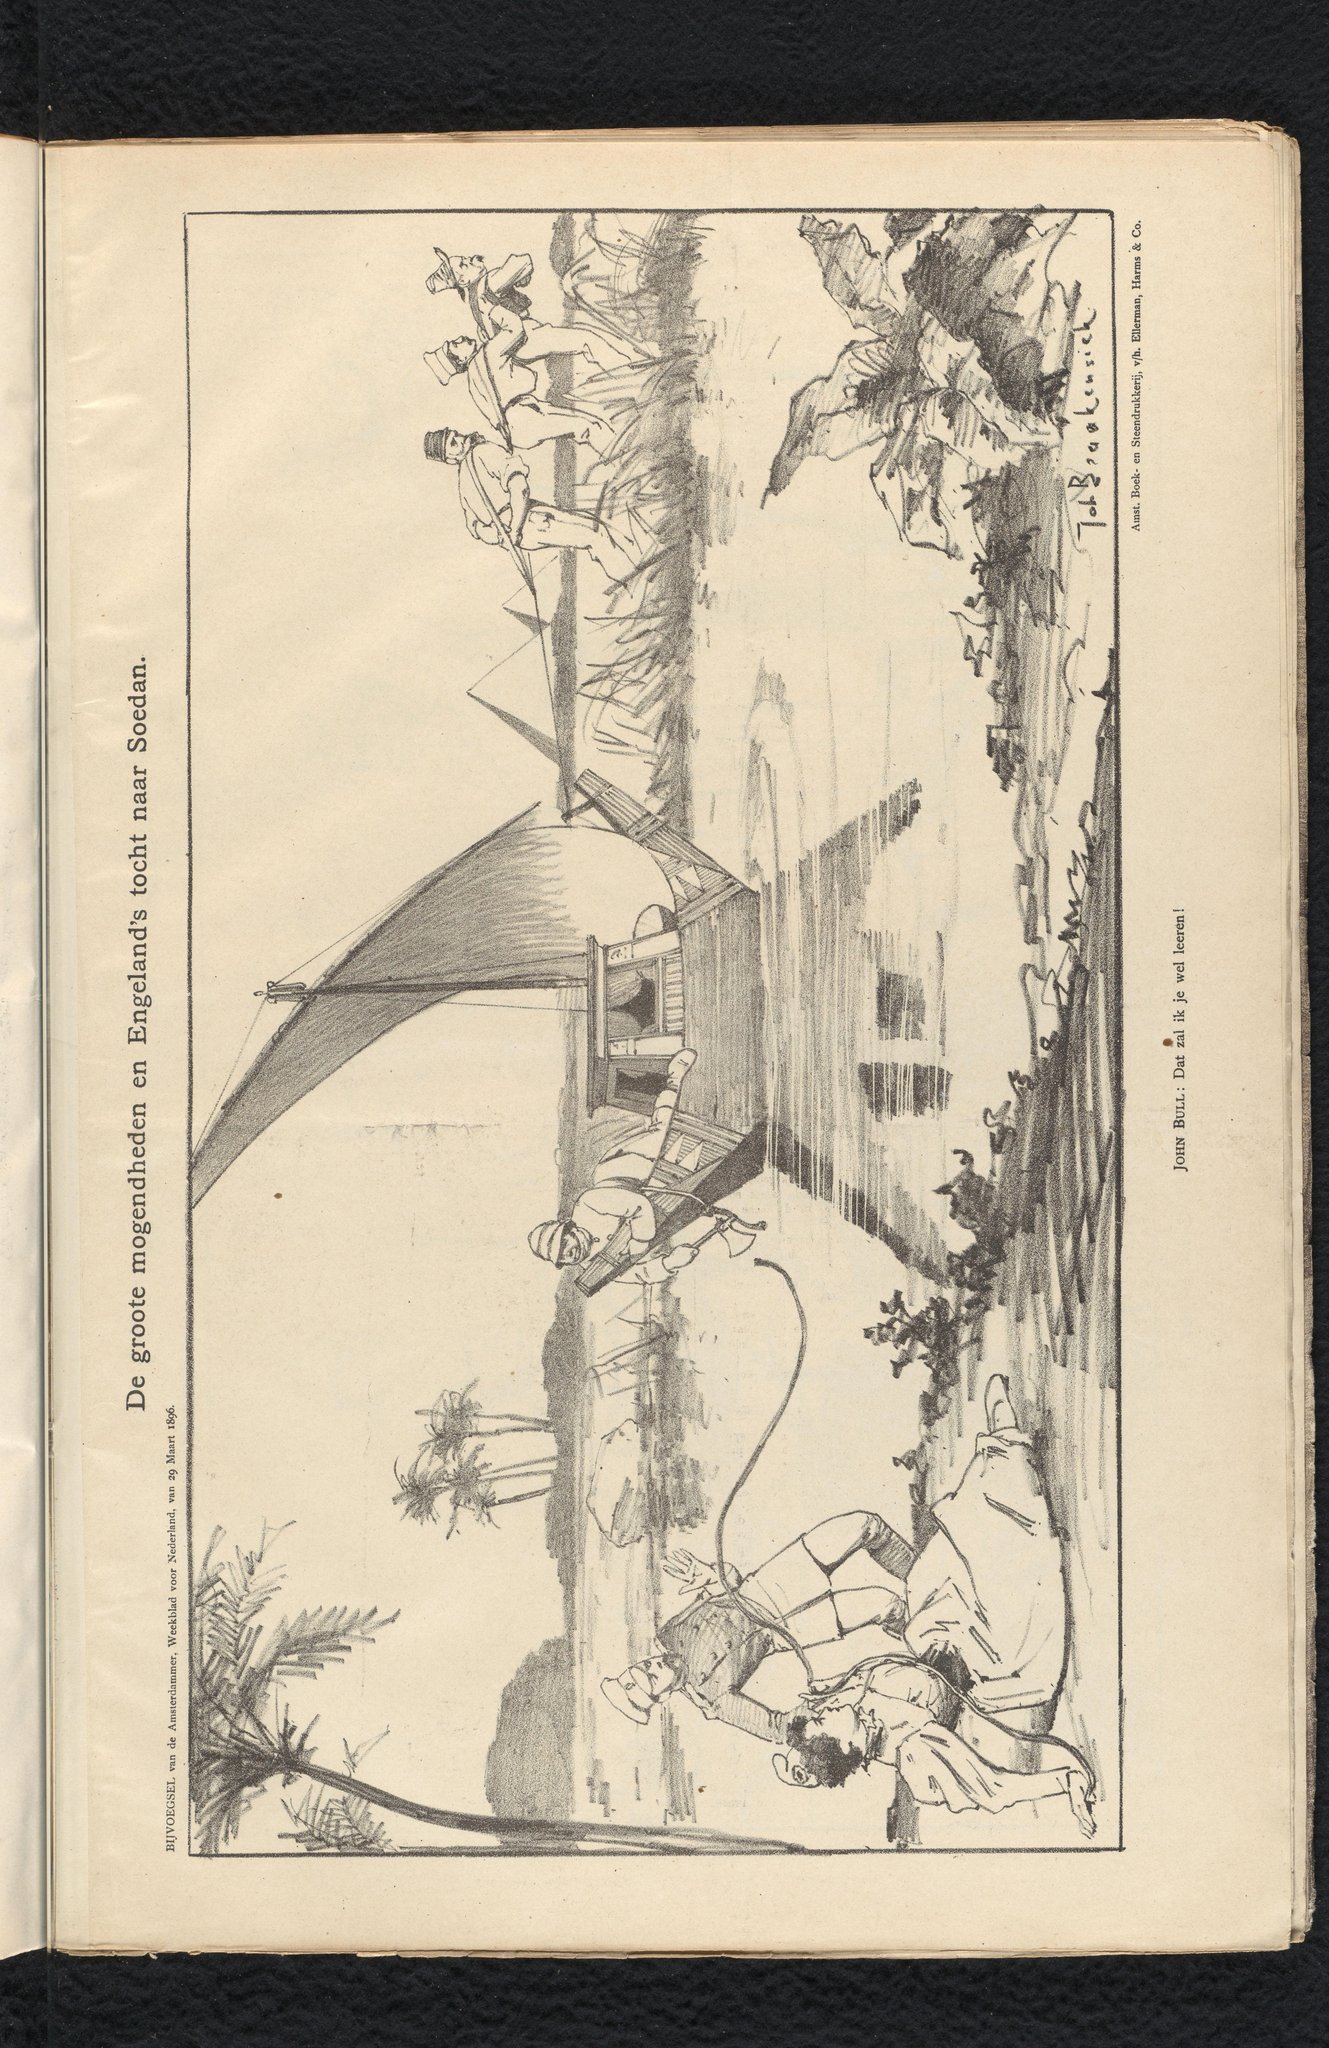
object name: cartoon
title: De groote mogendheden en Engeland's tocht naar Soedan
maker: johan braakensiek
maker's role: draughtsman, print maker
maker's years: 1858-1940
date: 1896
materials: paper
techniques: lithograph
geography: amsterdam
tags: personifications of countries, nations, states, districts, etc.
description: John Bull laat Rusland en Frankrijk achter op de oever van de Nijl terwijl hij verder vaart langs de piramides naar Soedan.